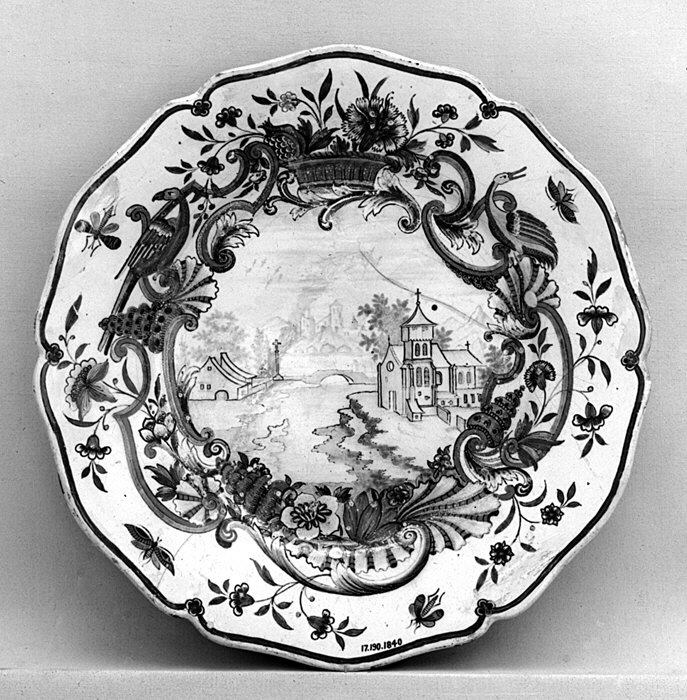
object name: plate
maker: pierre chapelle ii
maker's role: maker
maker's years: 1684-1760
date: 1725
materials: faience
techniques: glazing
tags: birds,houses,churches,flowers